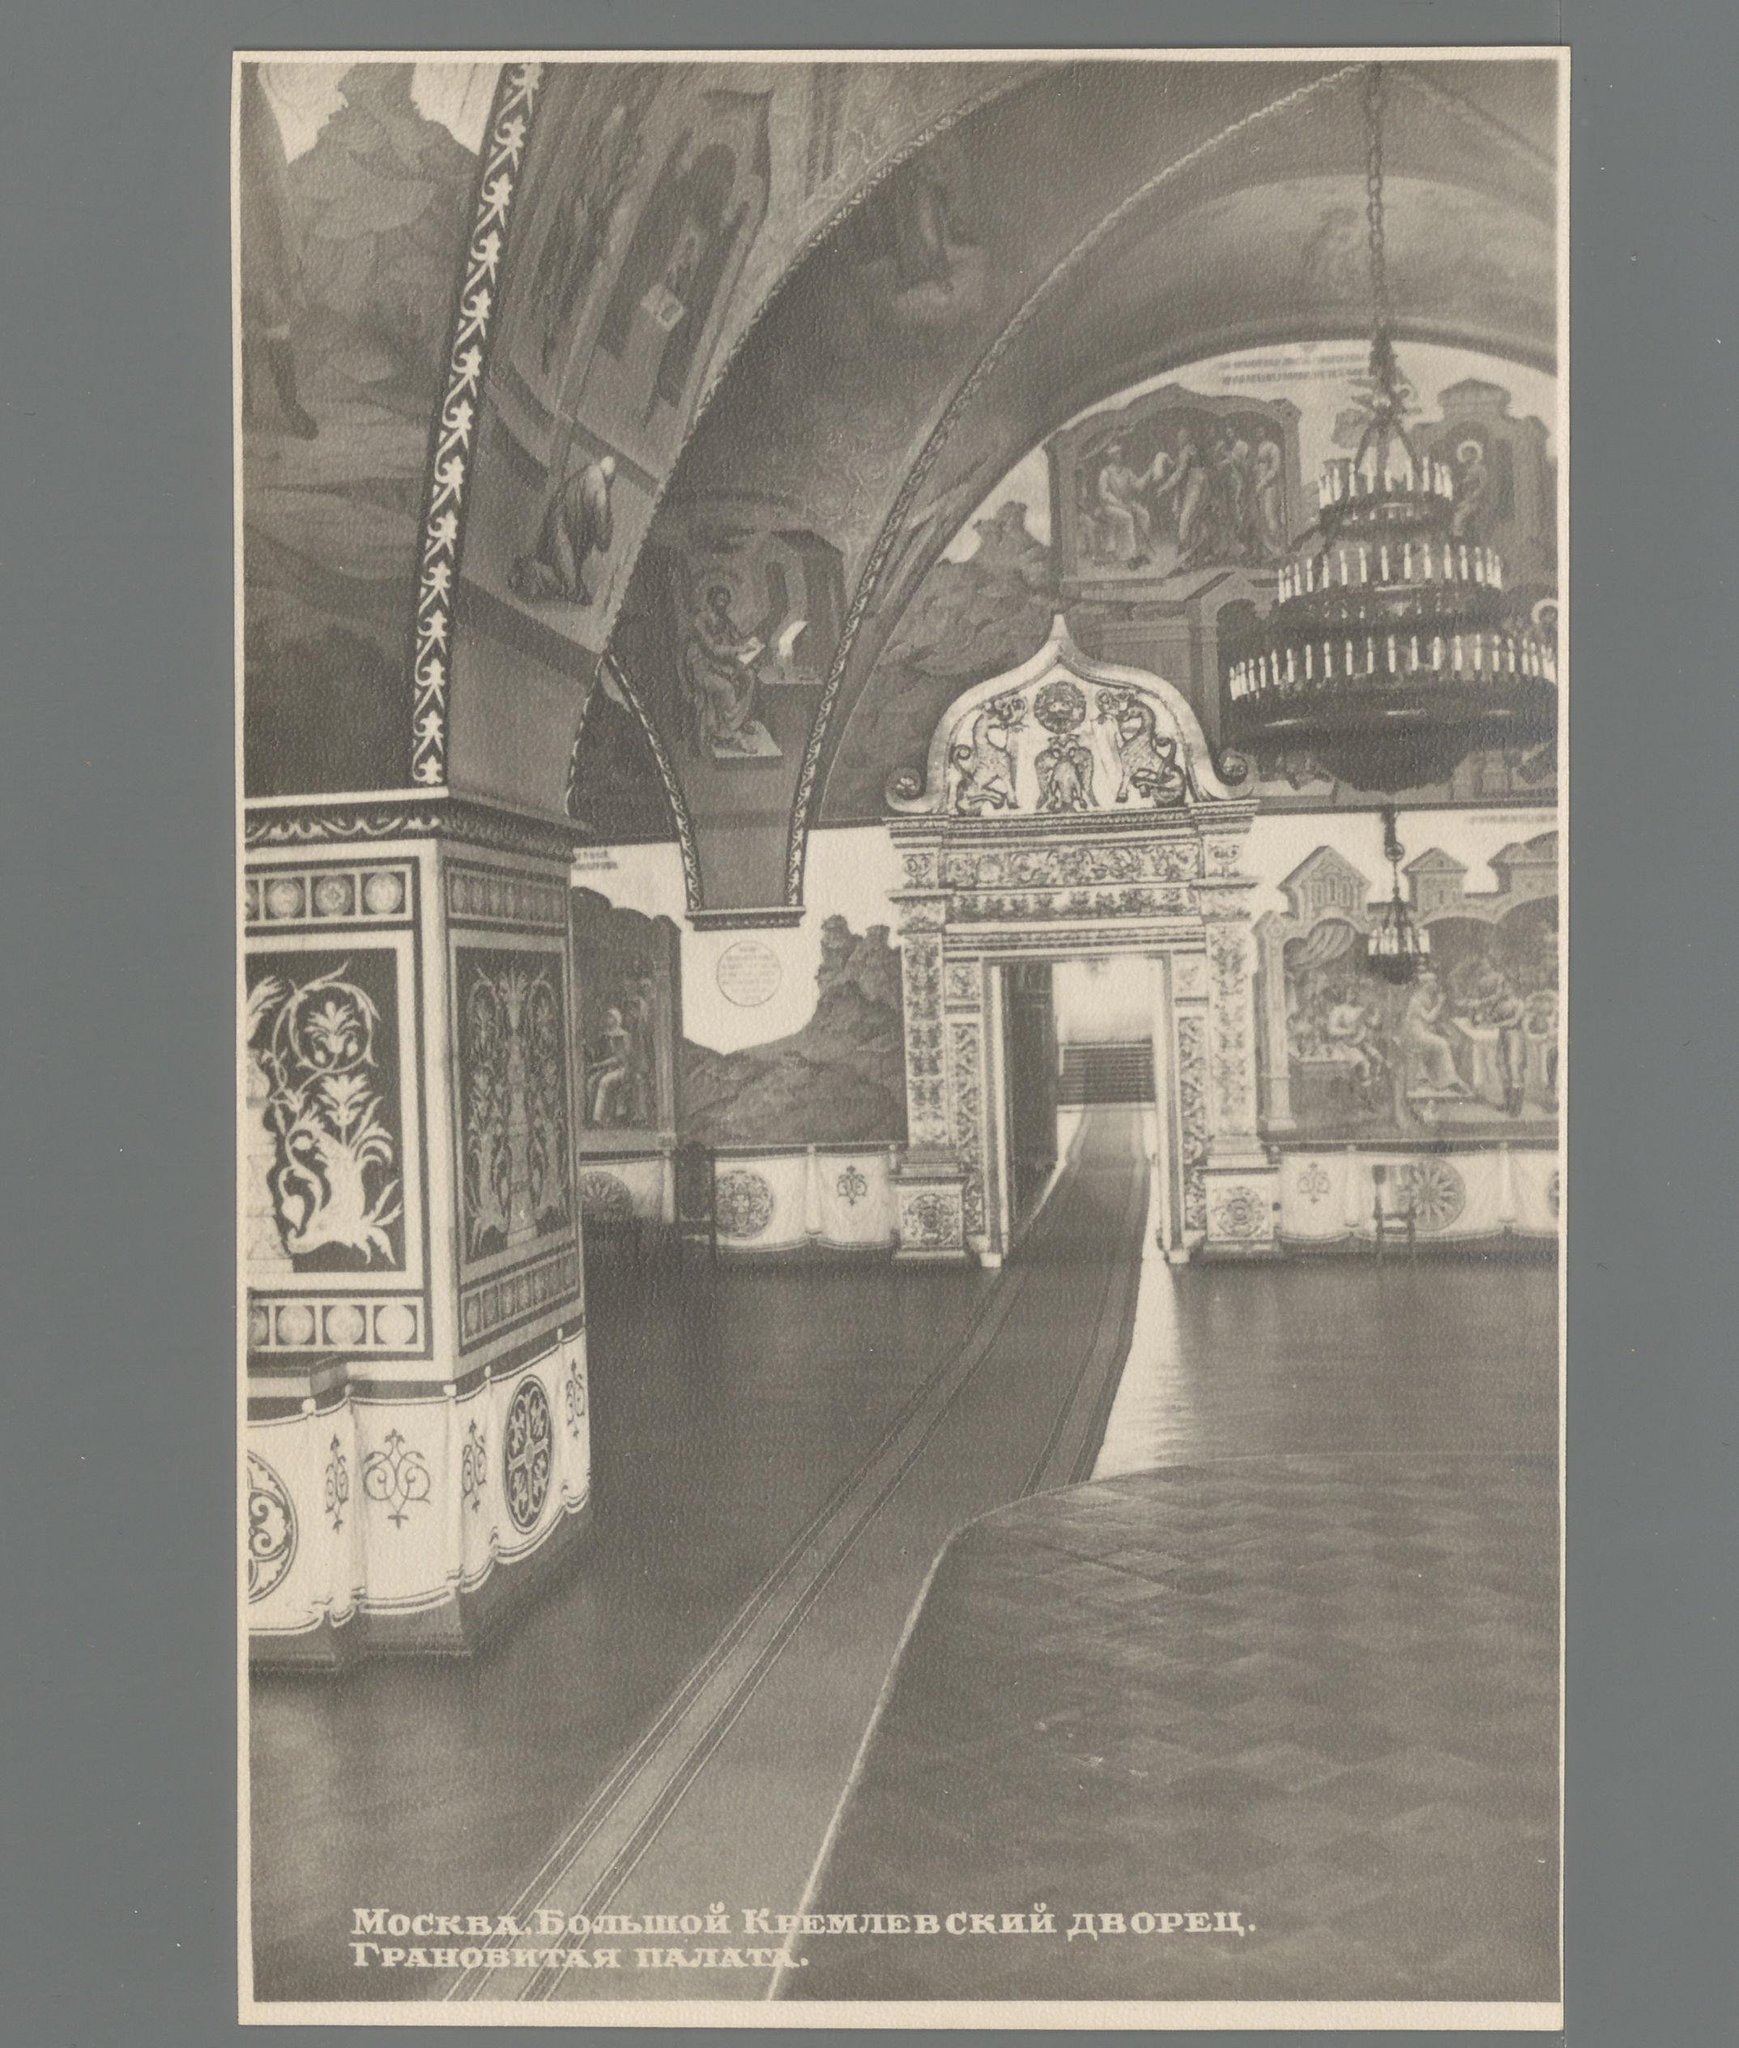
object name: photograph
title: Interieur van het Groot Paleis in het Kremlin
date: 1954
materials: paper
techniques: gelatin silver print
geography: moscow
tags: palace, interior of the house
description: De titel op object staat in het Russisch.